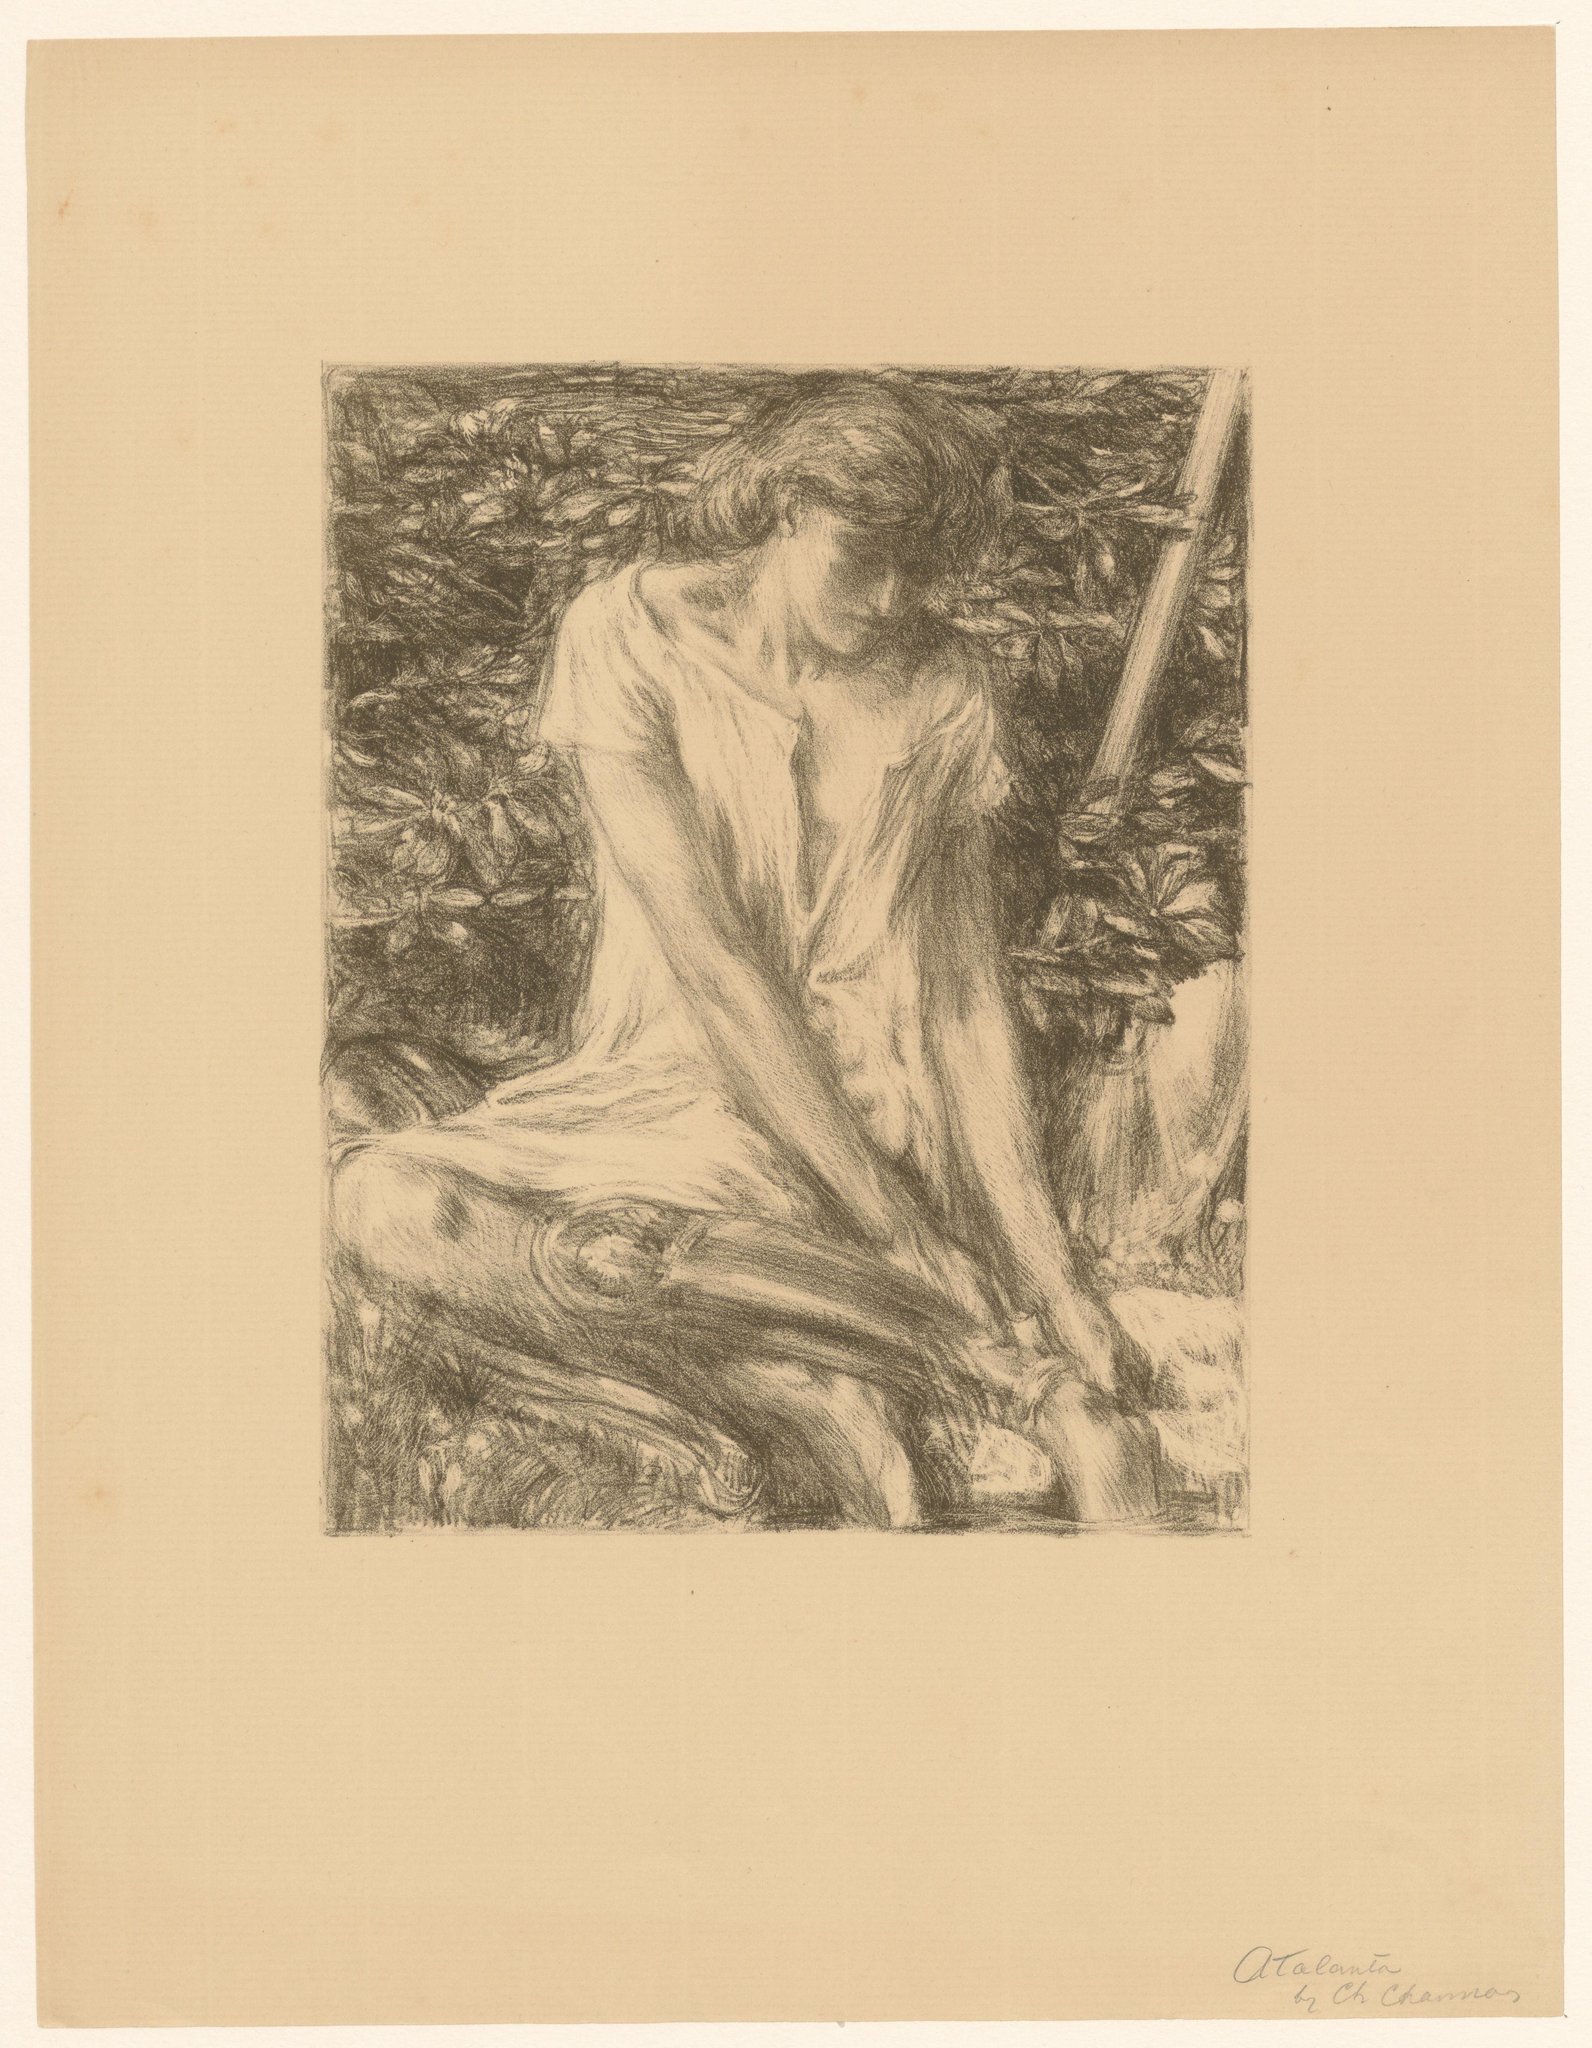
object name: print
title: Atalanta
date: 1893-1895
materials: paper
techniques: lithograph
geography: chelsea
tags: (story of) atalante, water course, washing one's feet - aa - in the open air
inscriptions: collector's mark: Lugt 2228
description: Prent uit: The Dial 4 (1895). Deze prent maakt ook onderdeel uit van de serie 'Portfolio No 3'.